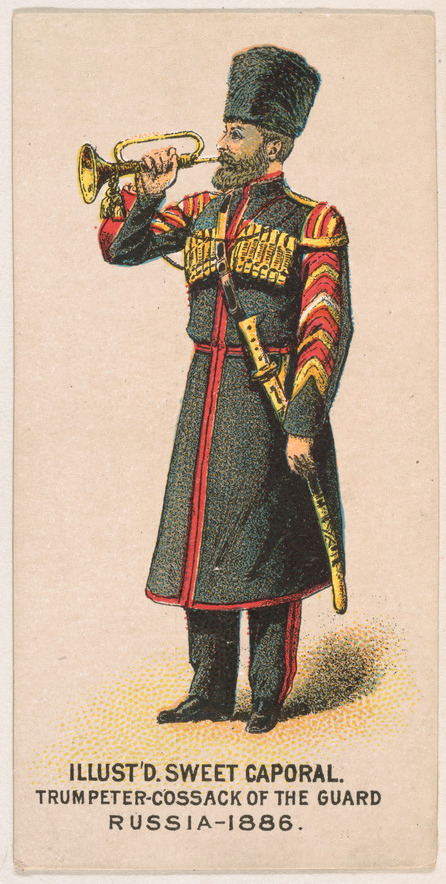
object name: print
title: Trumpeter Cossack of the Guard, Russia, 1886, from the Military Series (N224) issued by Kinney Tobacco Company to promote Sweet Caporal Cigarettes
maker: kinney brothers tobacco company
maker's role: publisher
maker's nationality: american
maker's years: 1869-2011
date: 1888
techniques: color lithograph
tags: military,swords,men,profiles,trumpets